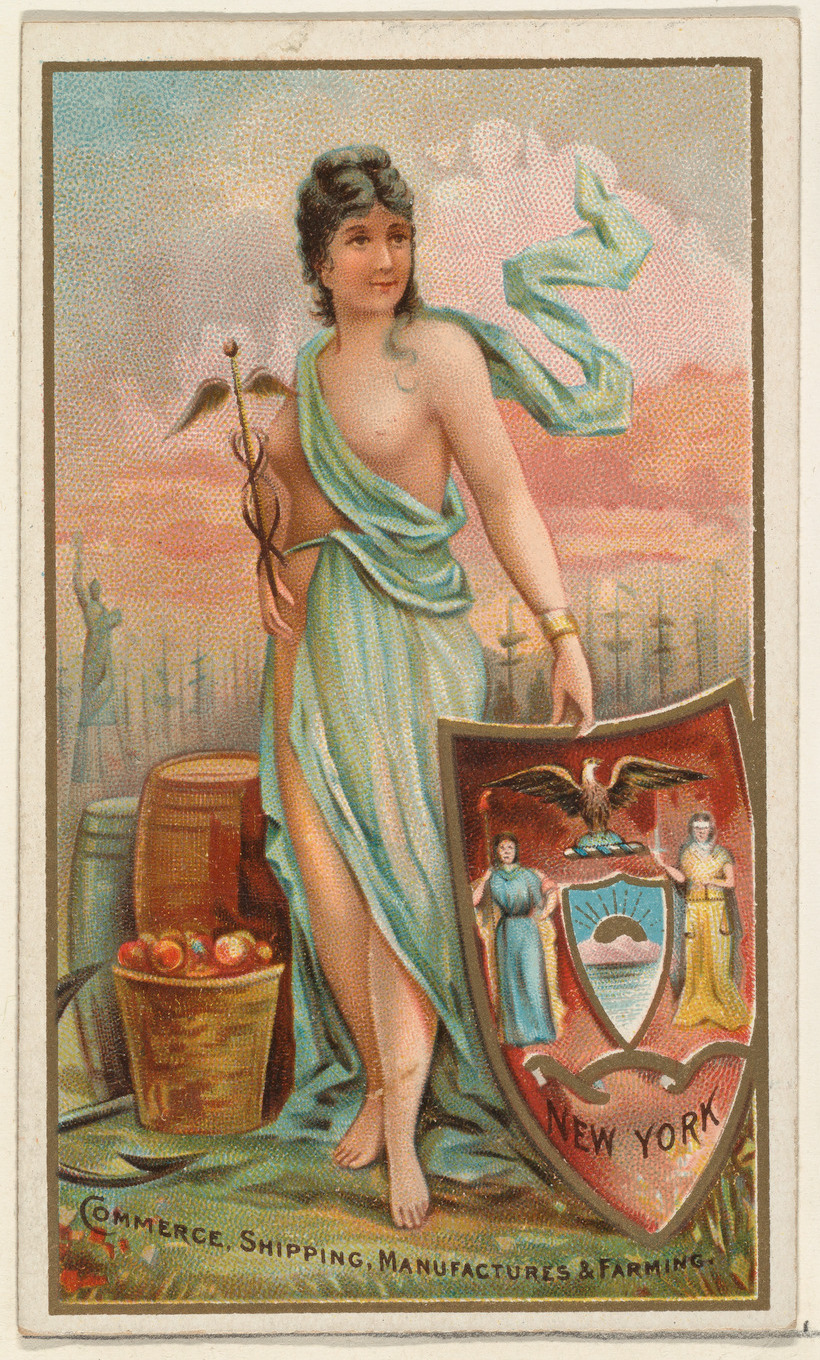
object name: print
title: New York, from the Industries of States series (N117) issued by Duke Sons & Co. to promote Honest Long Cut Tobacco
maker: w. duke, sons & co.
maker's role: publisher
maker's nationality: american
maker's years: 1870-1920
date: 1889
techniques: color lithograph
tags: eagles,shields,female nudes